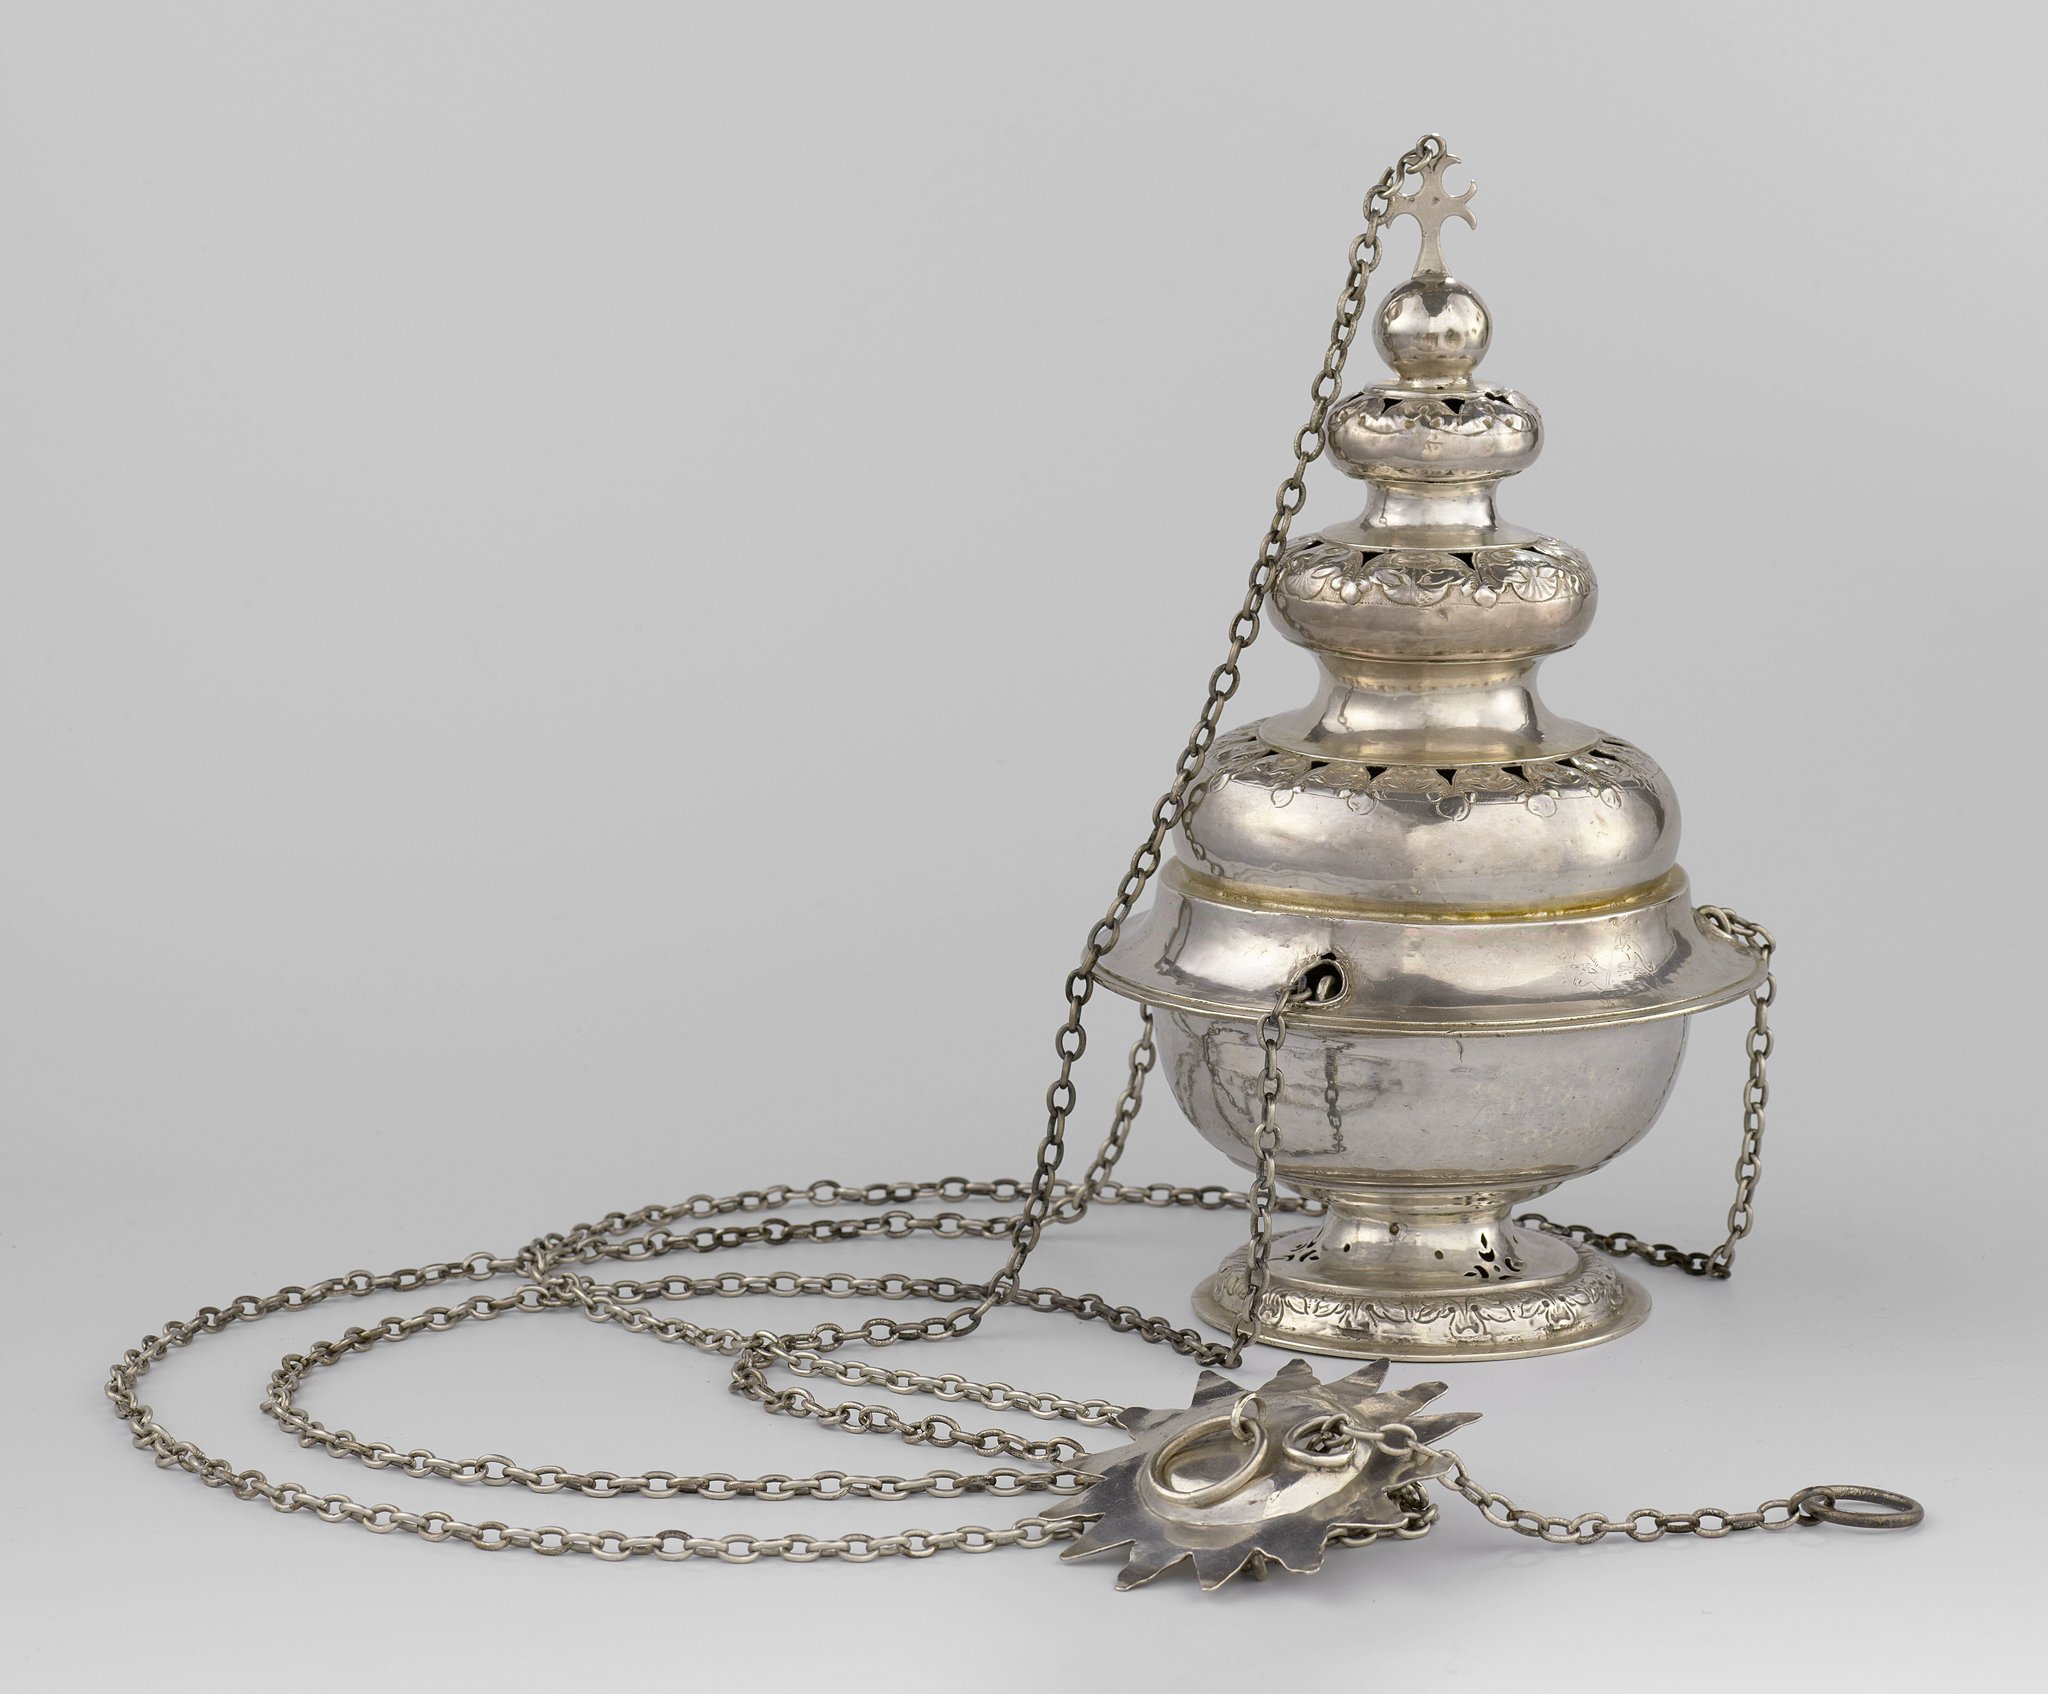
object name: censer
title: Wierookvat met gedreven bladversiering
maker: jan luyting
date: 1754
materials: silver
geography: haarlem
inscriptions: date letter: ‘V’, inscription, town mark, maker's mark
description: Thurible. Silver. Haarlem, 1754, by Jan Luyting.